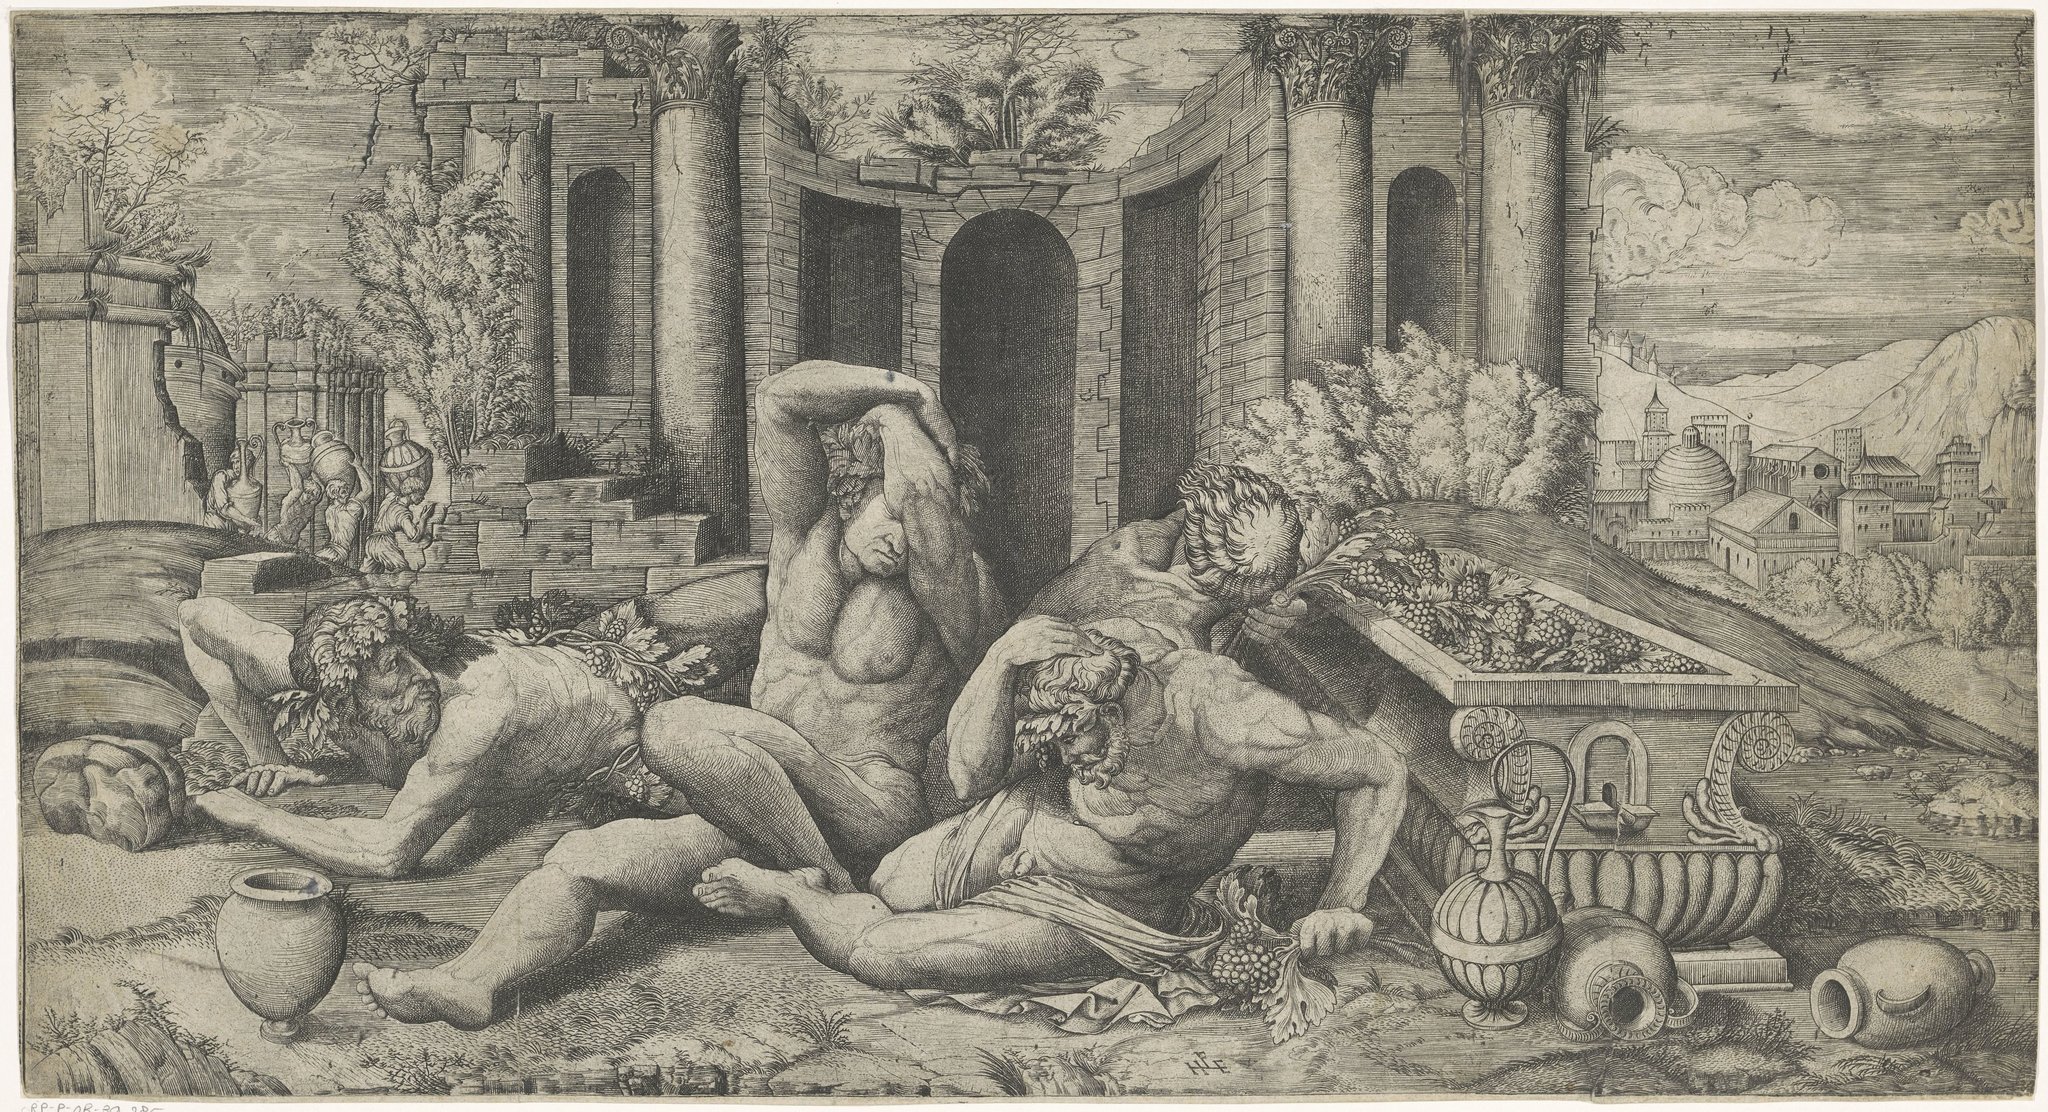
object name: print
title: De wijnoogst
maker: monogrammist hfe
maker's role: print maker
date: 1484-1552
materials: paper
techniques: engraving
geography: italy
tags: drunkenness, vintage, grape harvest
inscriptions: collector's mark: Lugt 240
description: Vier dronken mannen liggen naast een sarcofaag gevuld met druiven. Op de achtergrond een ruïne van een antieke tempel.